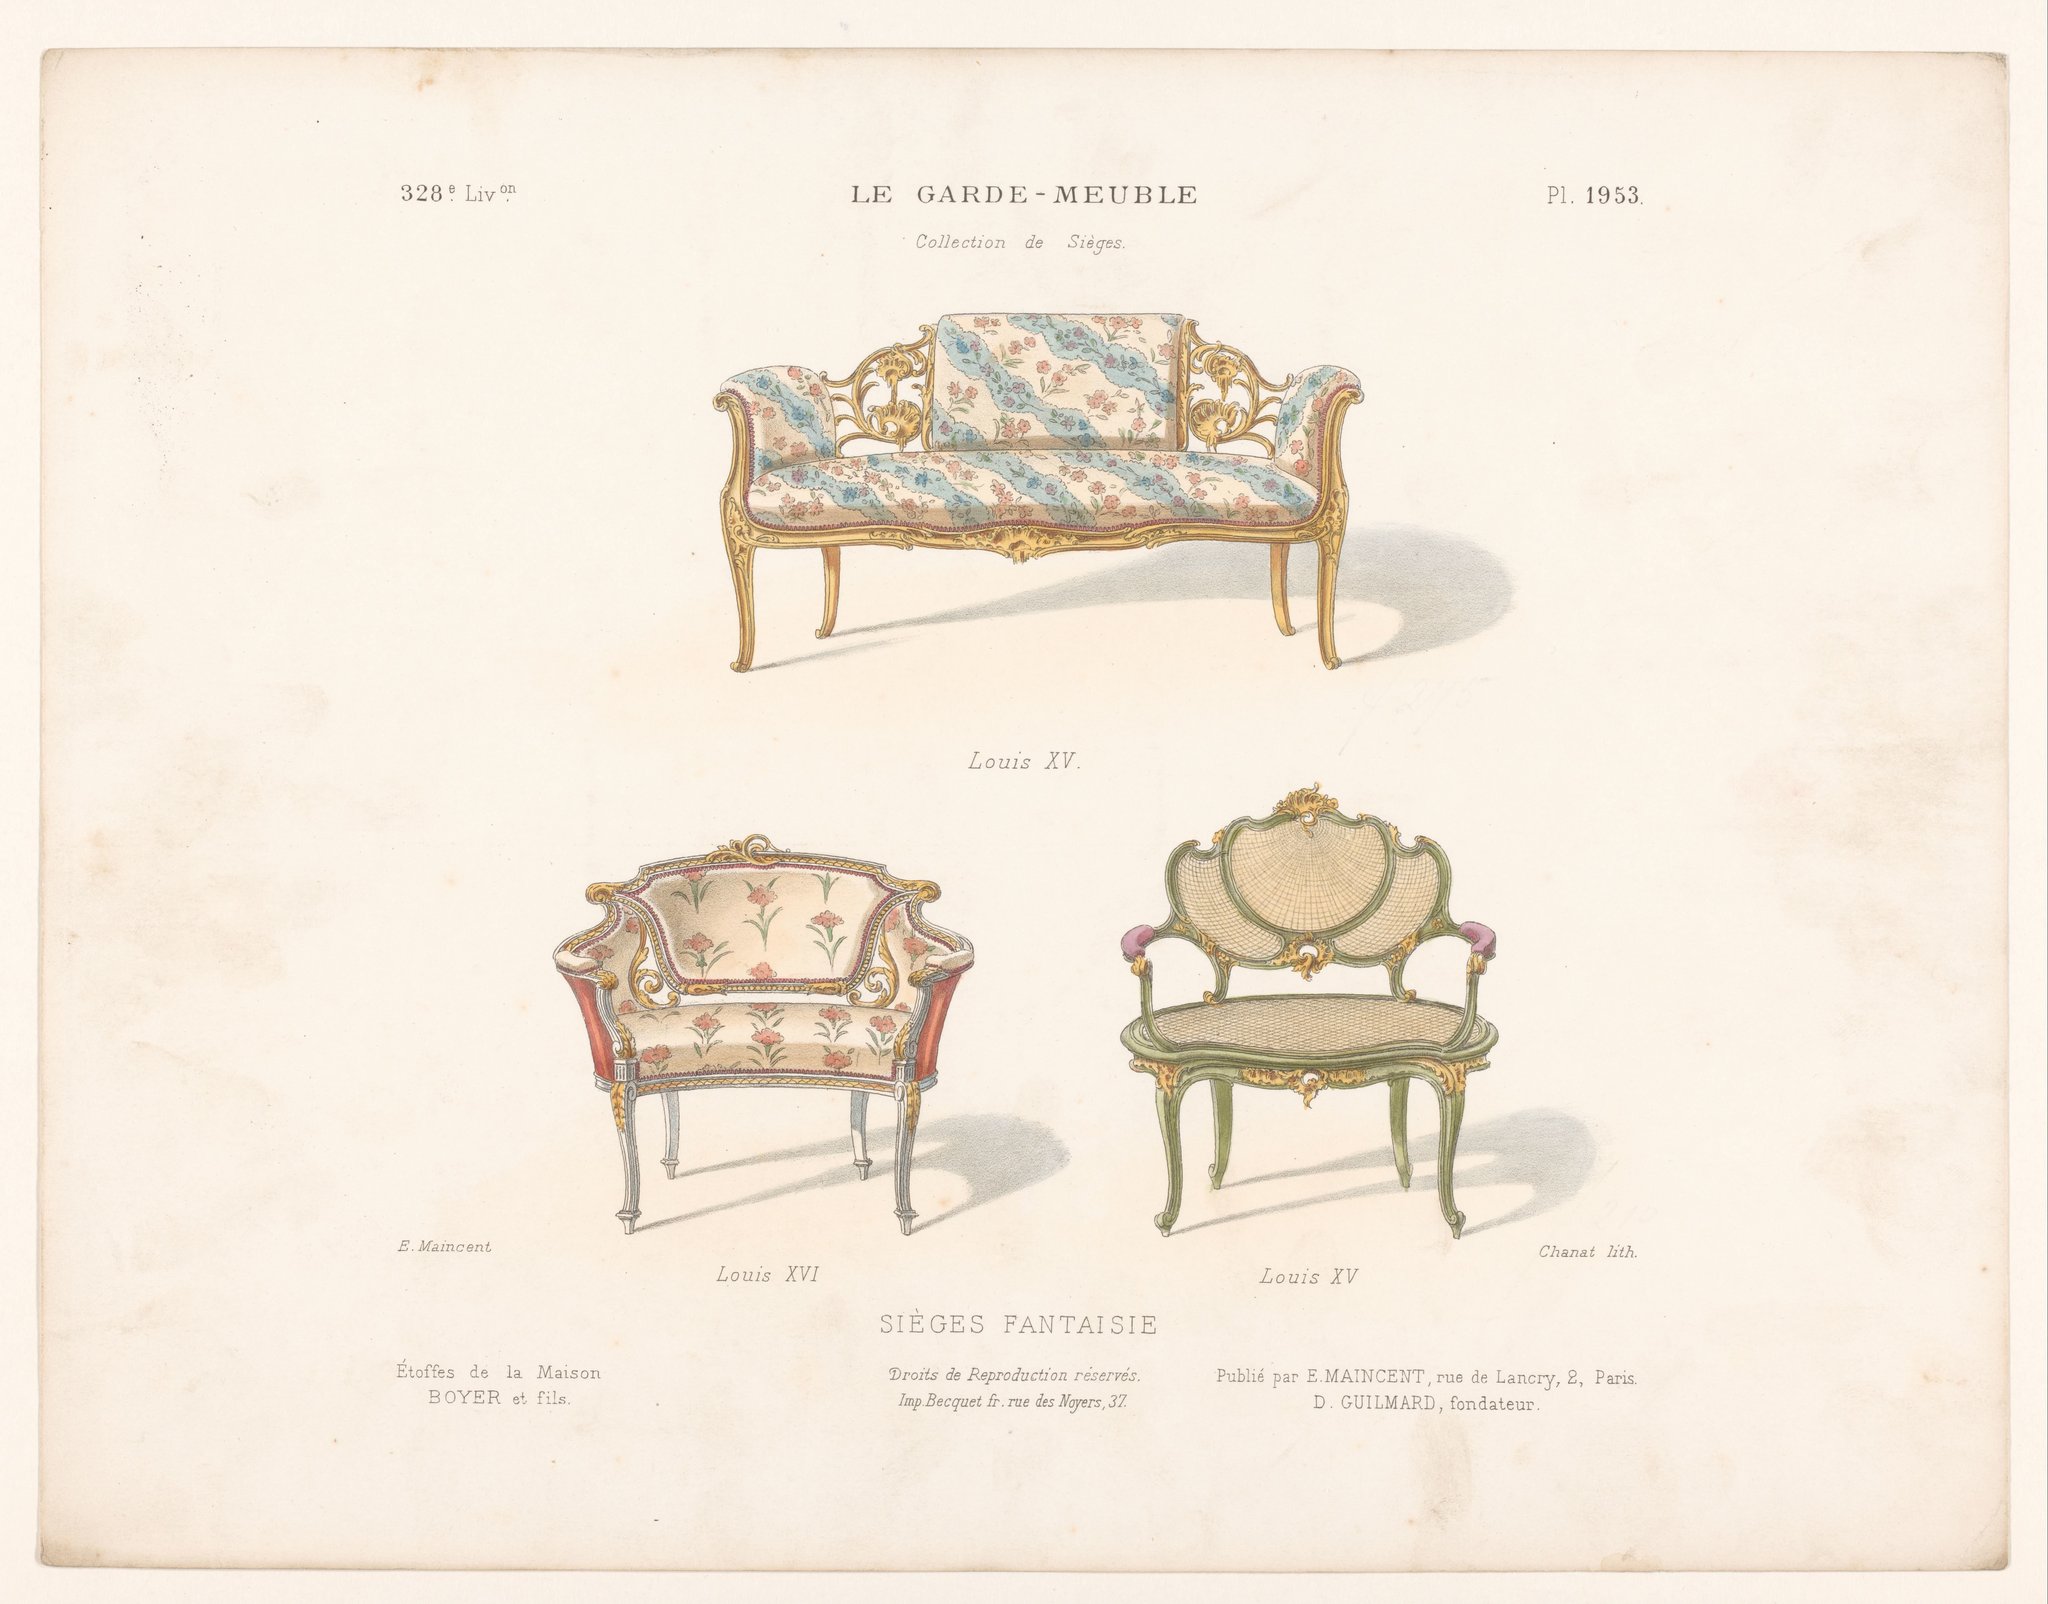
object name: print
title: Sièges fantaisie / Louis XV / Louis XVI / Louis XV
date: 1885-1895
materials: paper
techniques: hand coloring, lithograph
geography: paris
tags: seating furniture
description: Ieder Livraison in de serie Le Garde-Meuble bevat negen platen: drie 'sièges' (zitmeubels), drie 'meubles' (diverse meubels zoals tafels en kasten) en drie 'tentures' (gordijnen en draperieën).